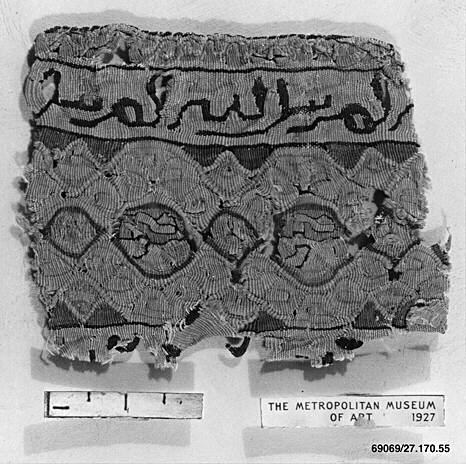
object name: band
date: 1001-1200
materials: linen, silk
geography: egypt